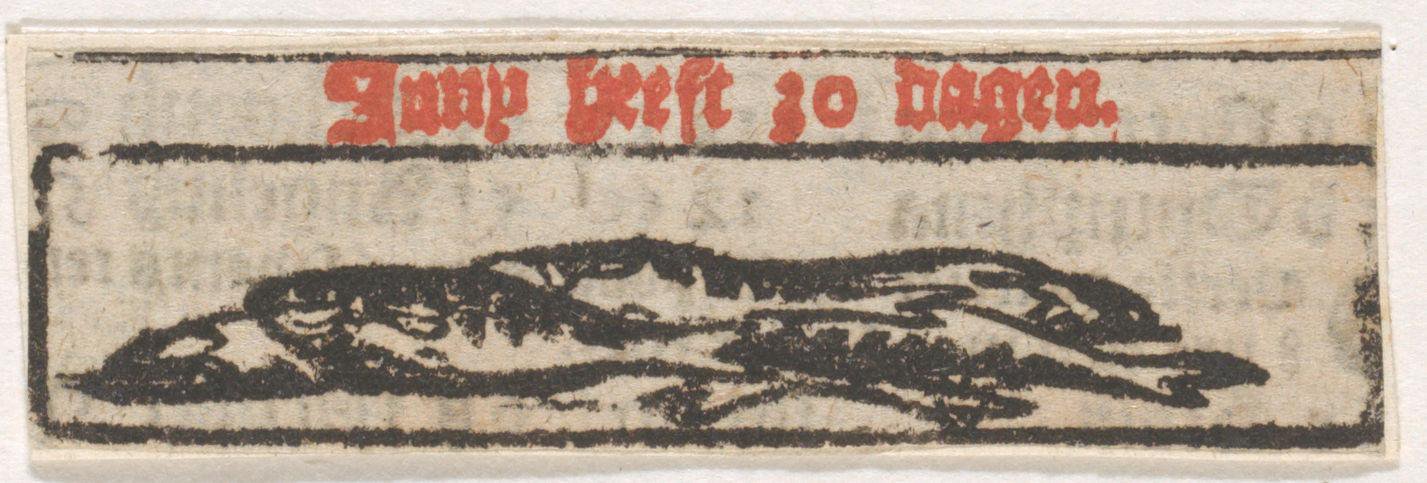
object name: print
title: Juni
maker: dirck de bray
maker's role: draughtsman, painter, print maker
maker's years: 1625-1694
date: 1672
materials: paper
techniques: letterpress printing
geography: netherlands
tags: june ~ other concepts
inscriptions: collector's mark: Lugt 2228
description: Een aantal vissen. In de bovenmarge een regel Nederlandse tekst.